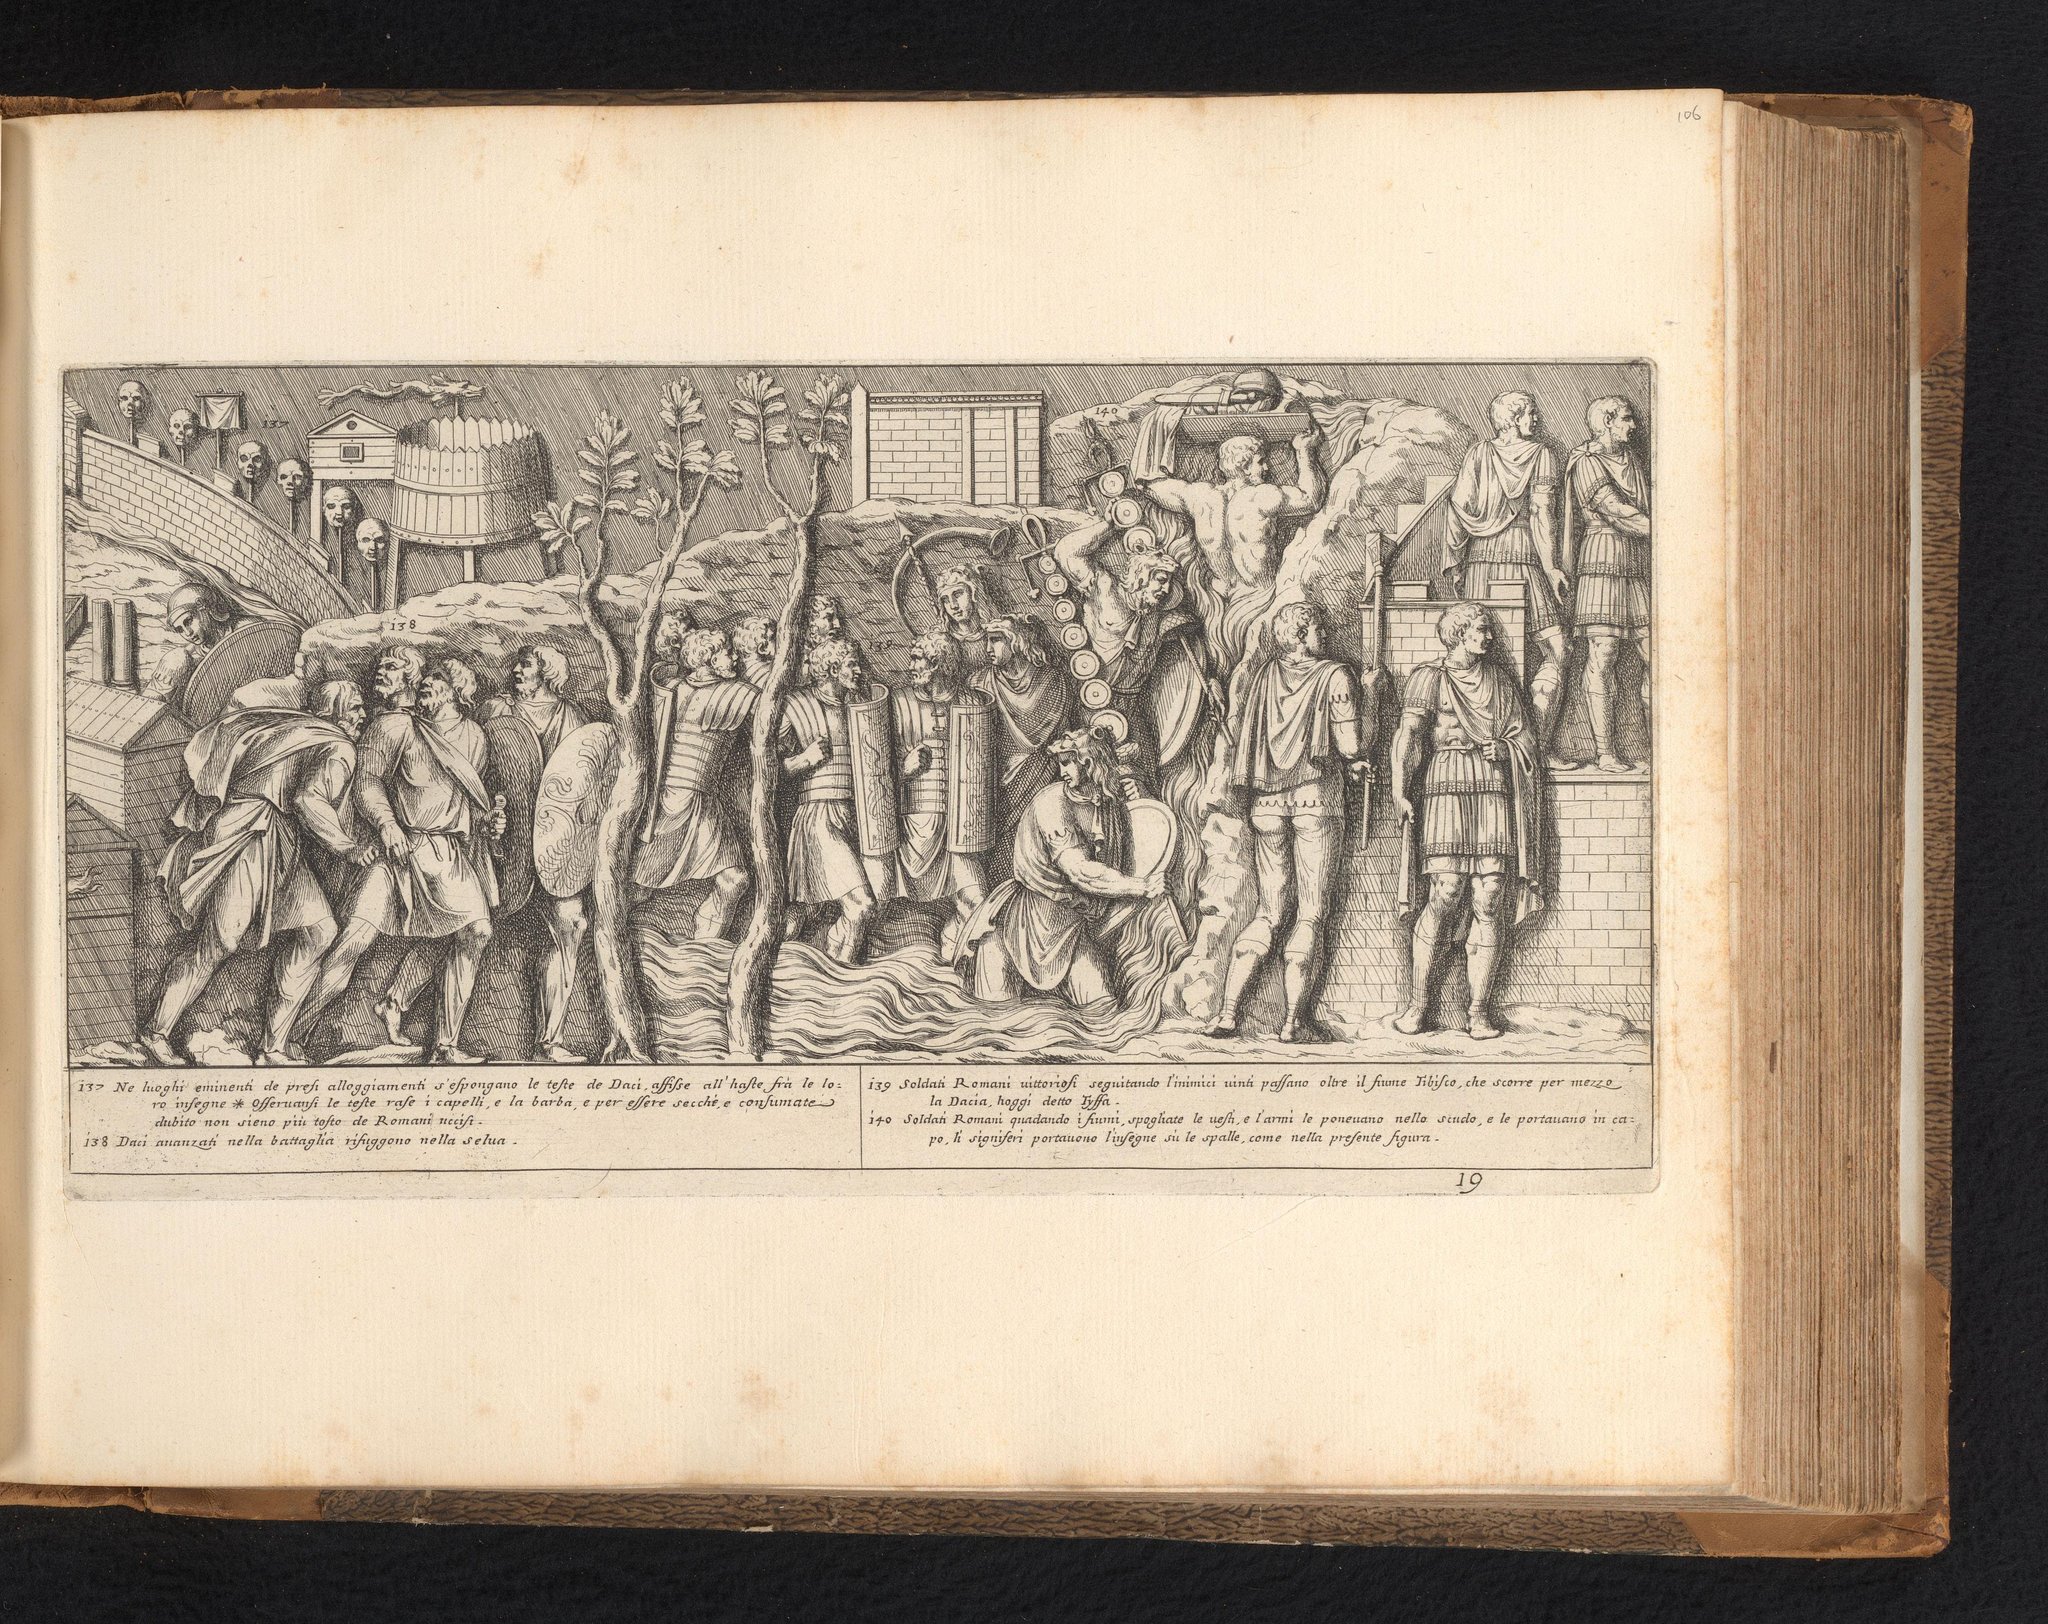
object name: album leaf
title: Colonna Traiana eretta dal senato, e popolo Romano all' imperatore Traiano Augusto nel suo foro in Rom (...)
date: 1637-1691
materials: paper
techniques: etching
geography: rome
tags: triumphal column with helical friezes, piece of sculpture, reproduction of a piece of sculpture, the soldier; the soldier's life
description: Detail van het spiraalvormige gebeeldhouwde fries op de Zuil van Trajanus. Het fries toont de oorlogen tussen de Romeinen en de Daciërs. Verklarende nummers in de ondermarge. Prent maakt deel uit van een album.